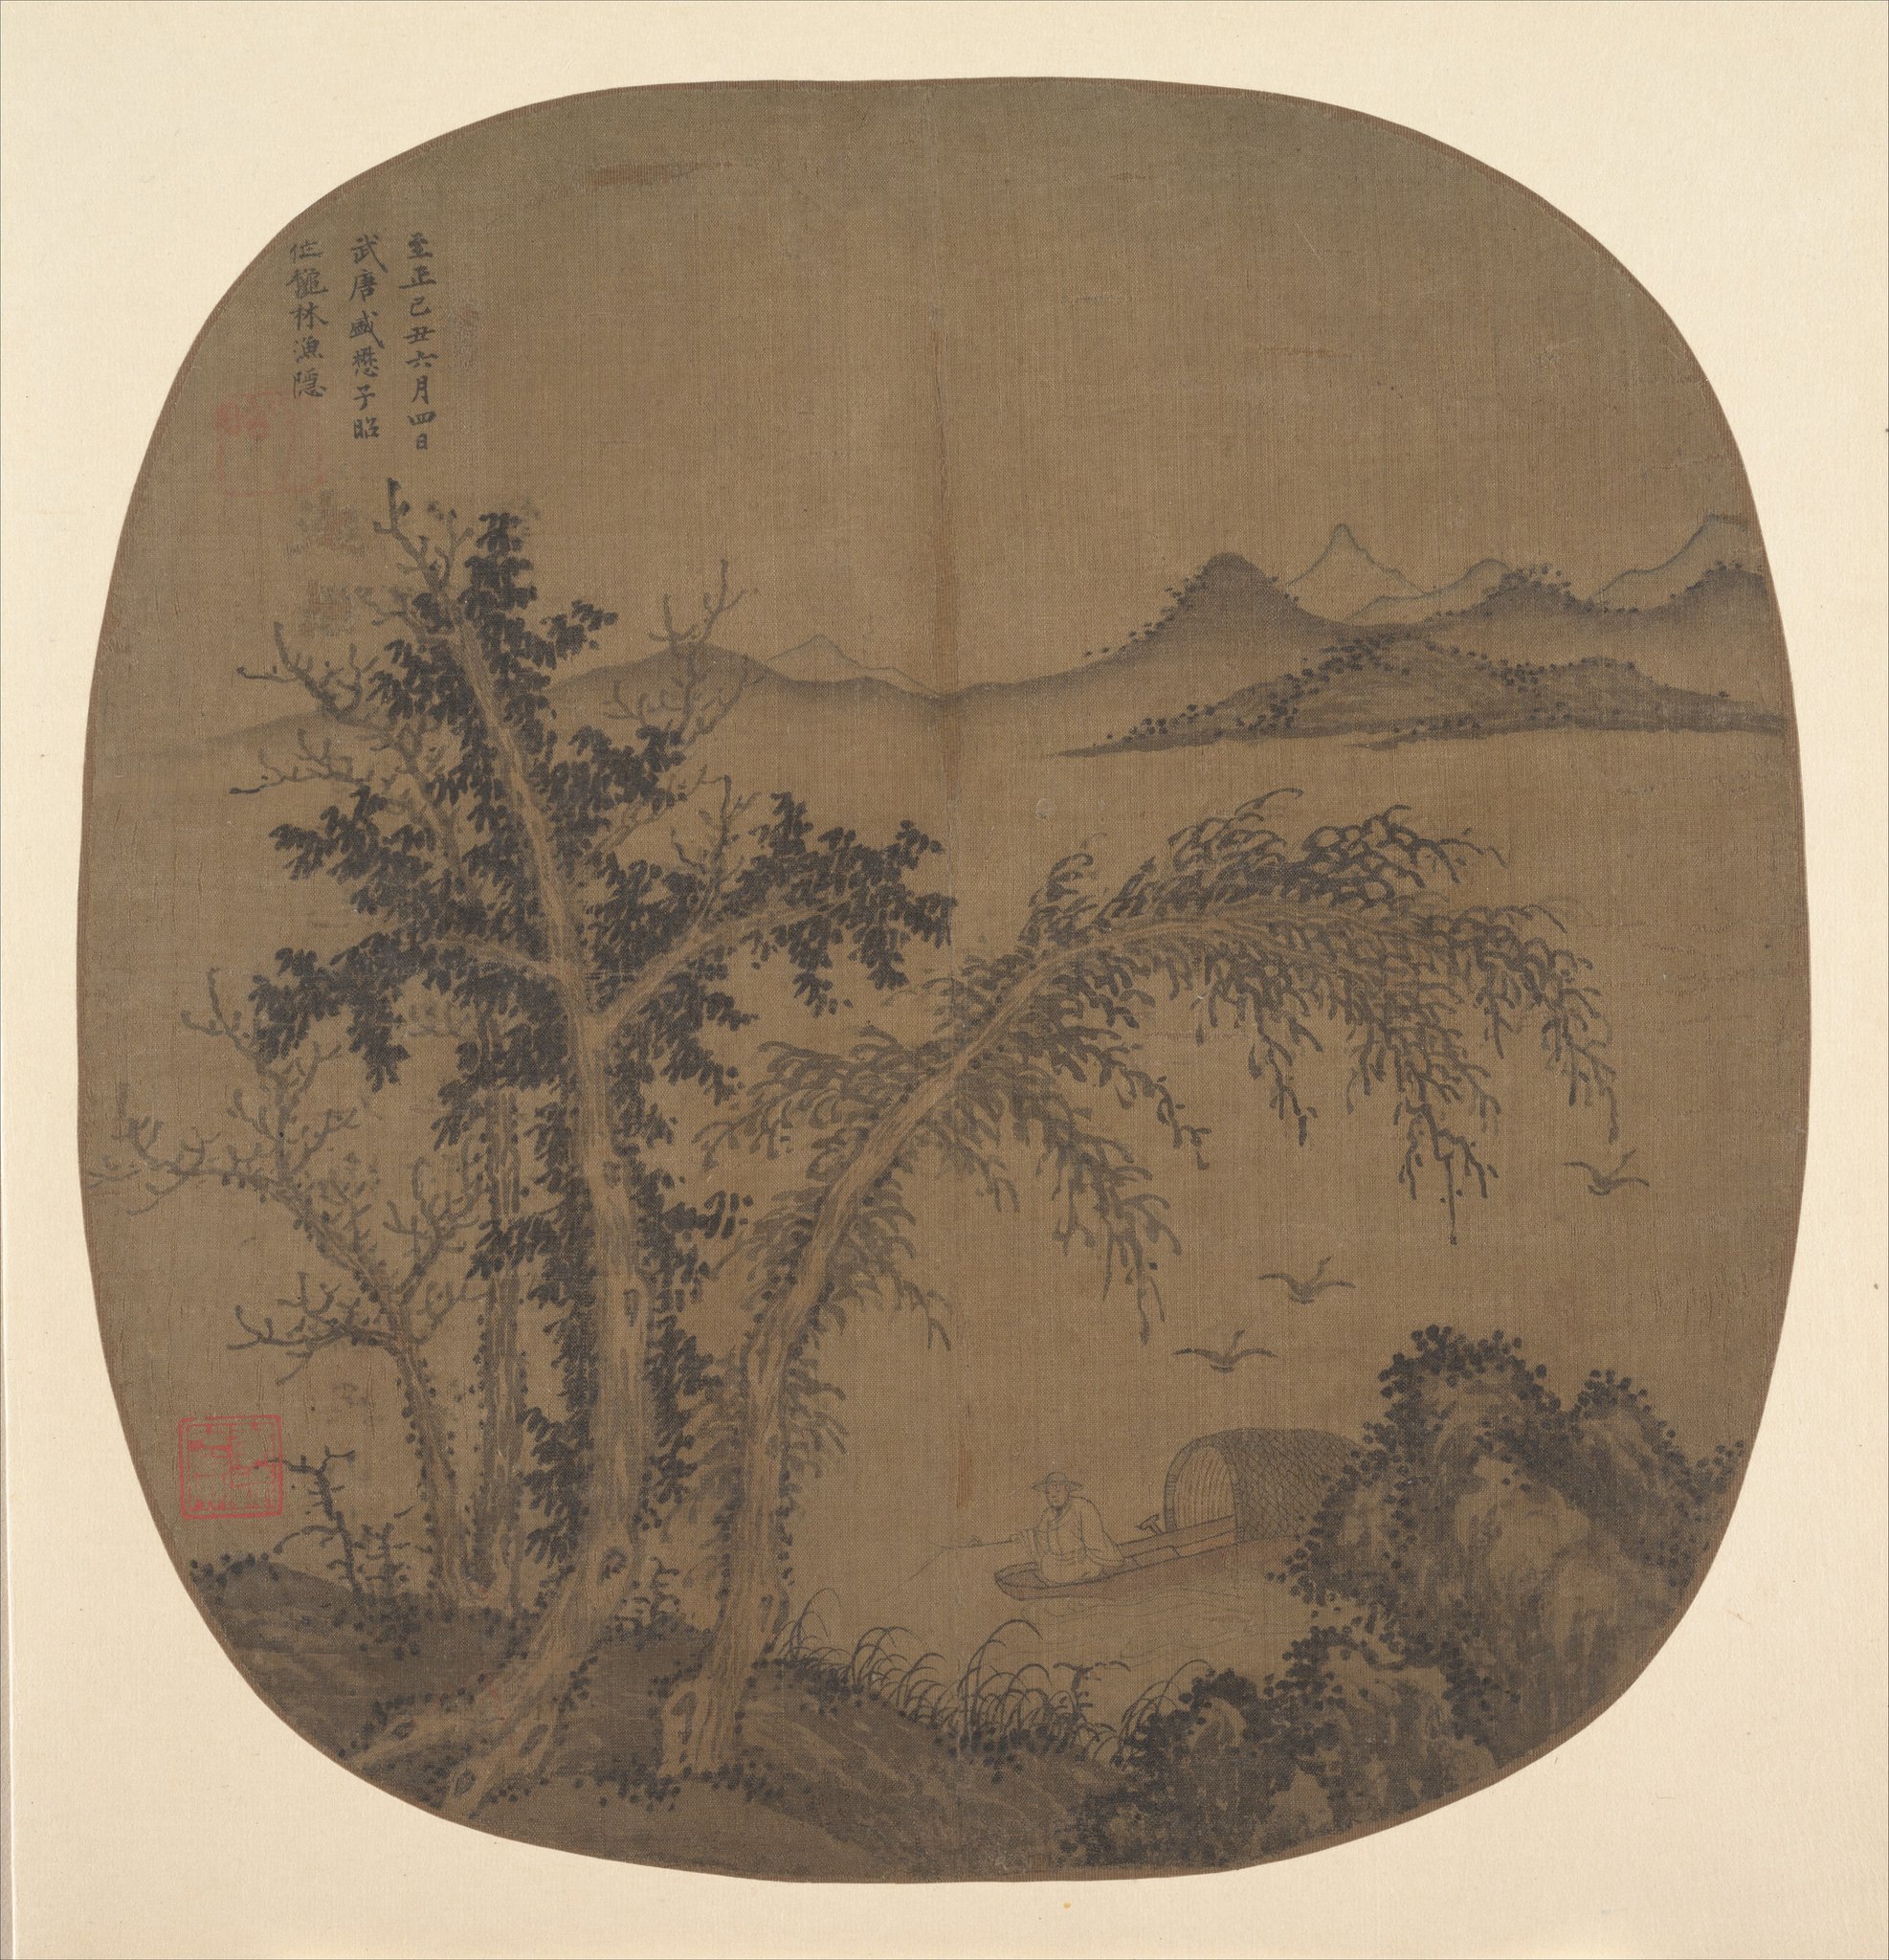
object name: fan mounted a an album leaf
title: Recluse Fisherman, Autumn Trees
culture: chinese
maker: sheng mao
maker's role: artist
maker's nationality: chinese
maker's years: 1310-1360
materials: ink, silk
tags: men,fishing,landscapes,trees